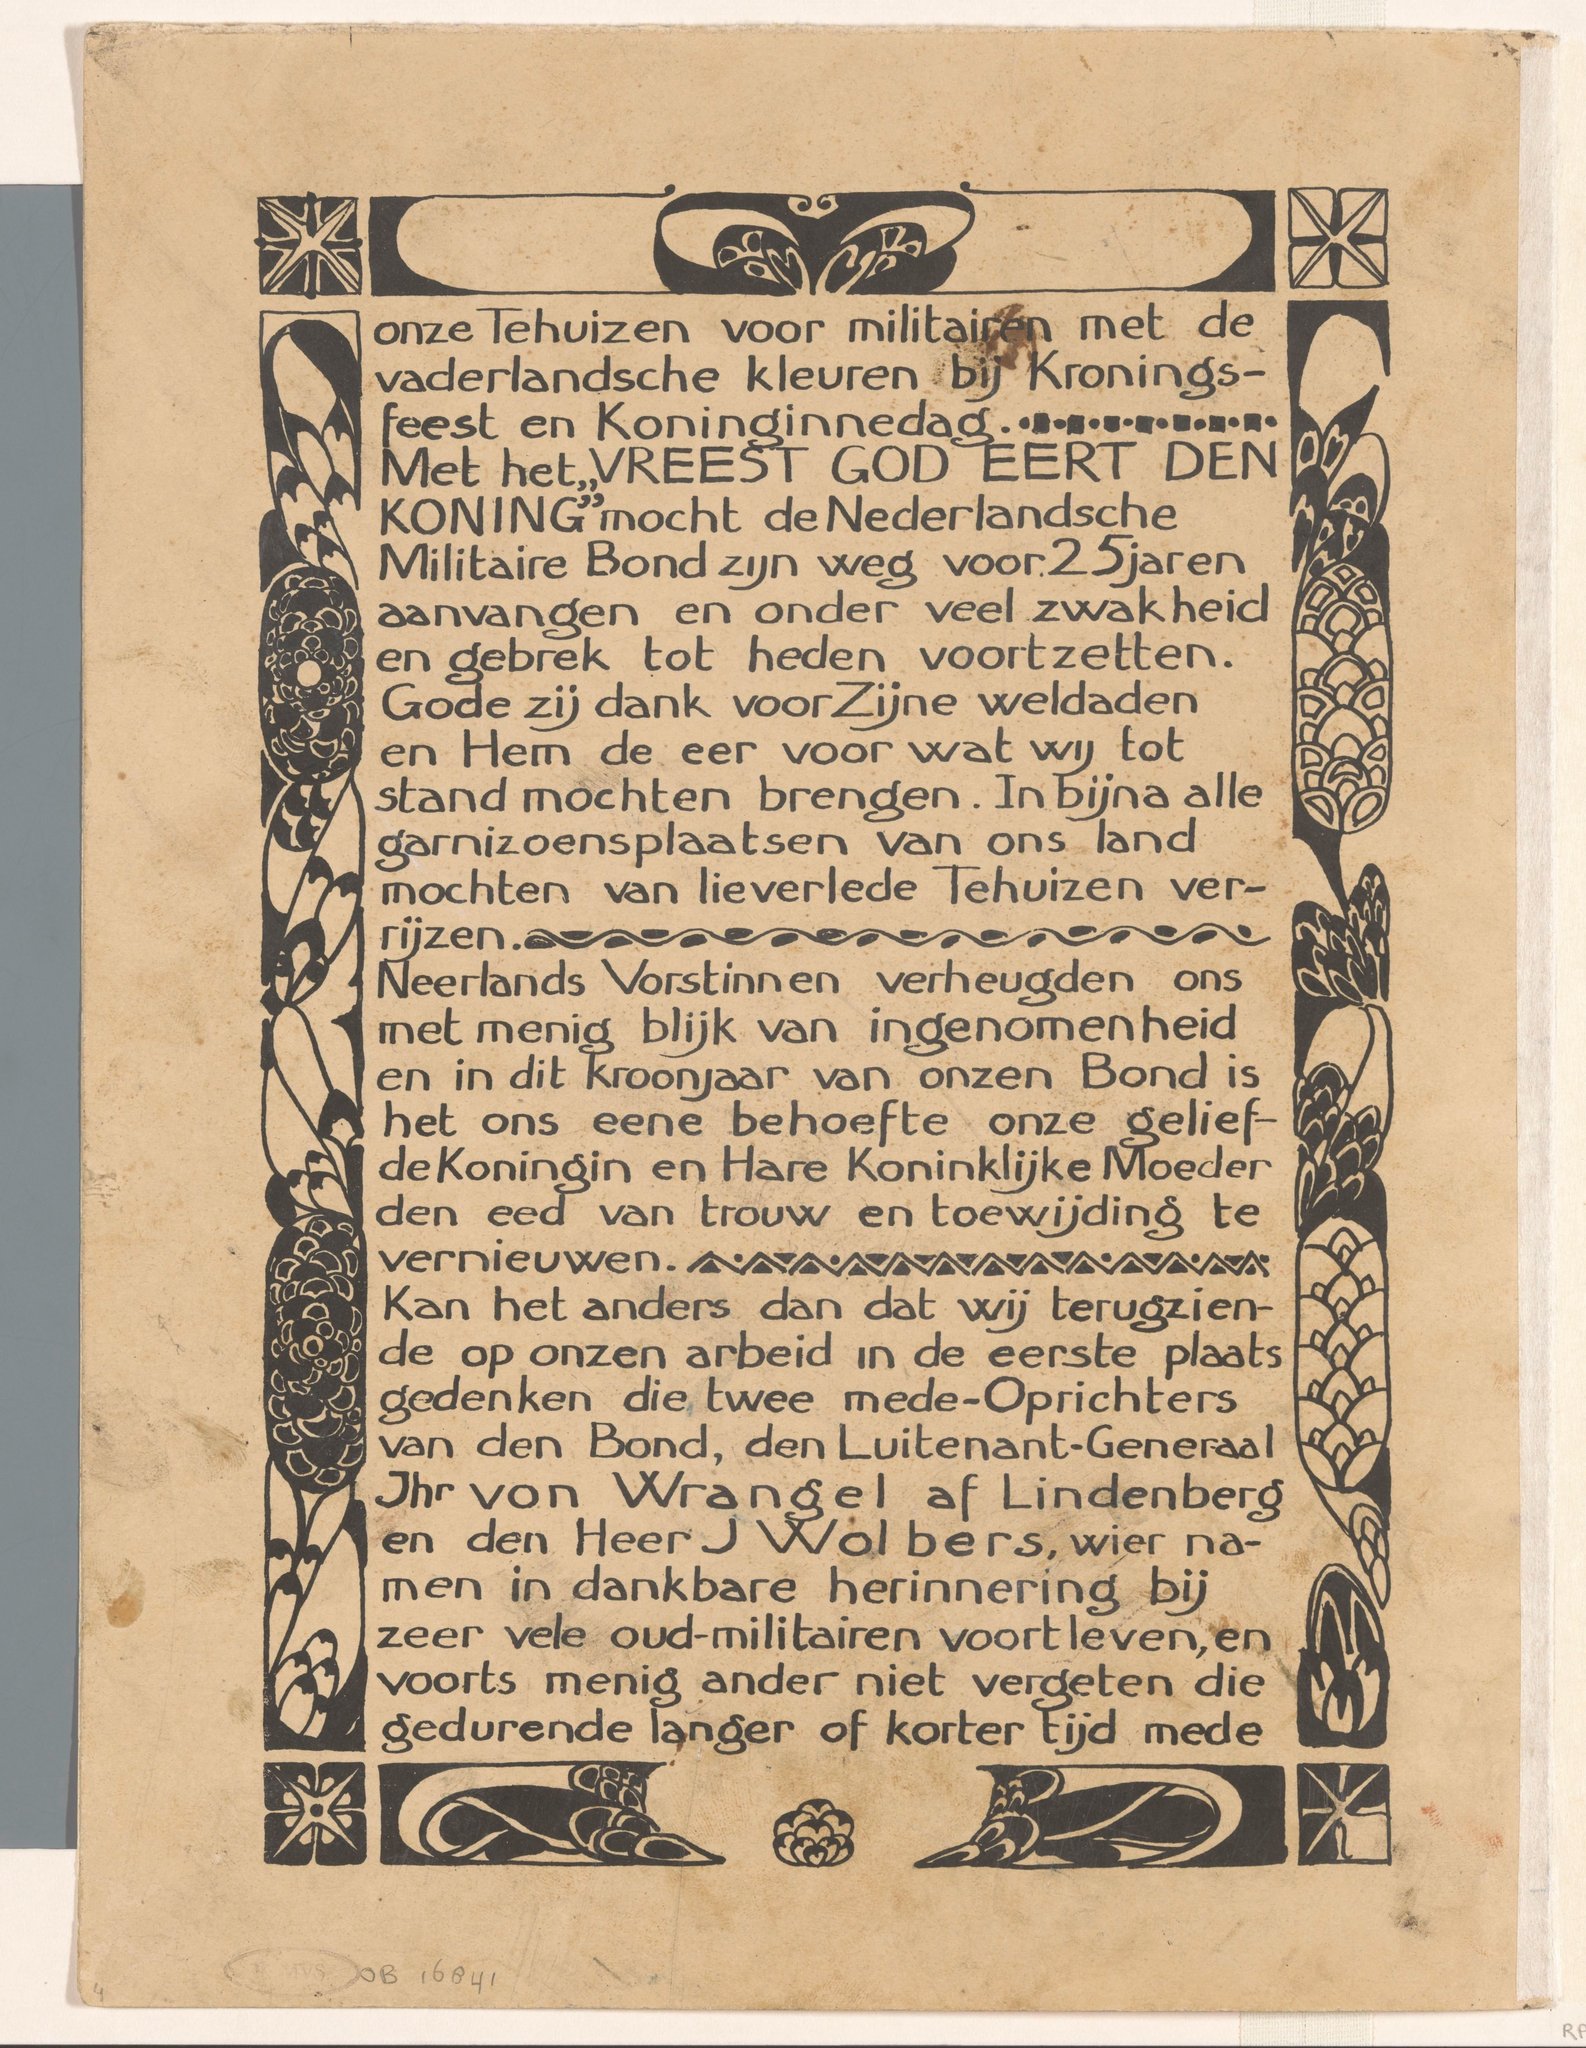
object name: print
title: Inleiding met ornamentrand voor Onder Neerlands vlag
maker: carel adolph lion cachet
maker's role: draughtsman, print maker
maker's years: 1864-1945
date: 1899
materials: paper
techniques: lithograph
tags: foliage, tendrils, branches ~ ornament - aa - stylized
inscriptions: collector's mark: Lugt 2228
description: Ornamentrand met plant- en bloemmotieven. In het midden een gedeelte van een introductietekst over de Nederlandse Militaire Bond. Deze prent maakt deel uit van een vouwblad.